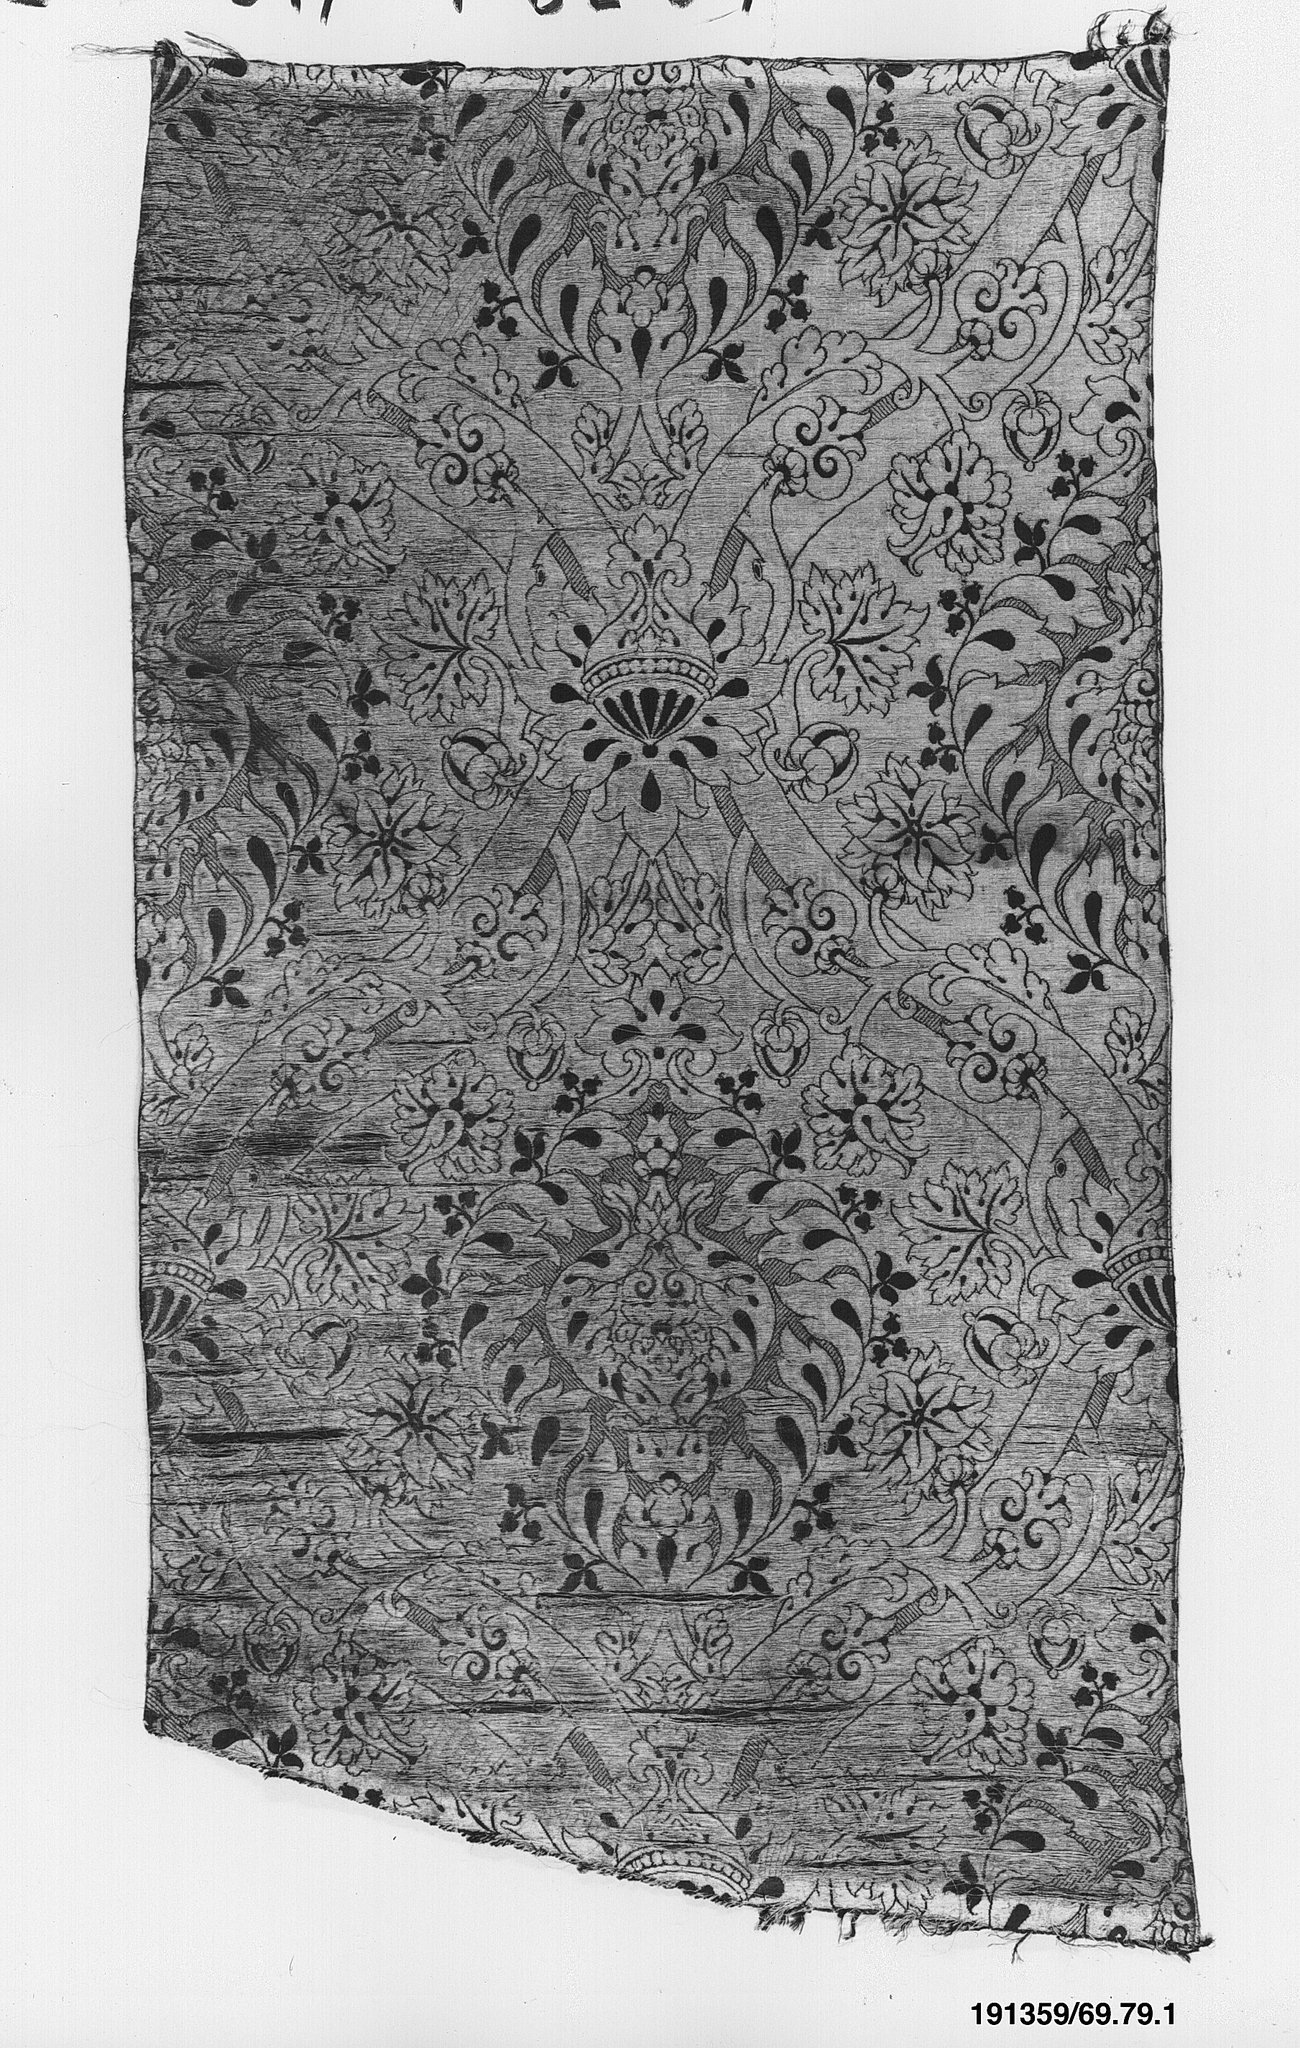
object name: length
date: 1601-1700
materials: metal thread, silk